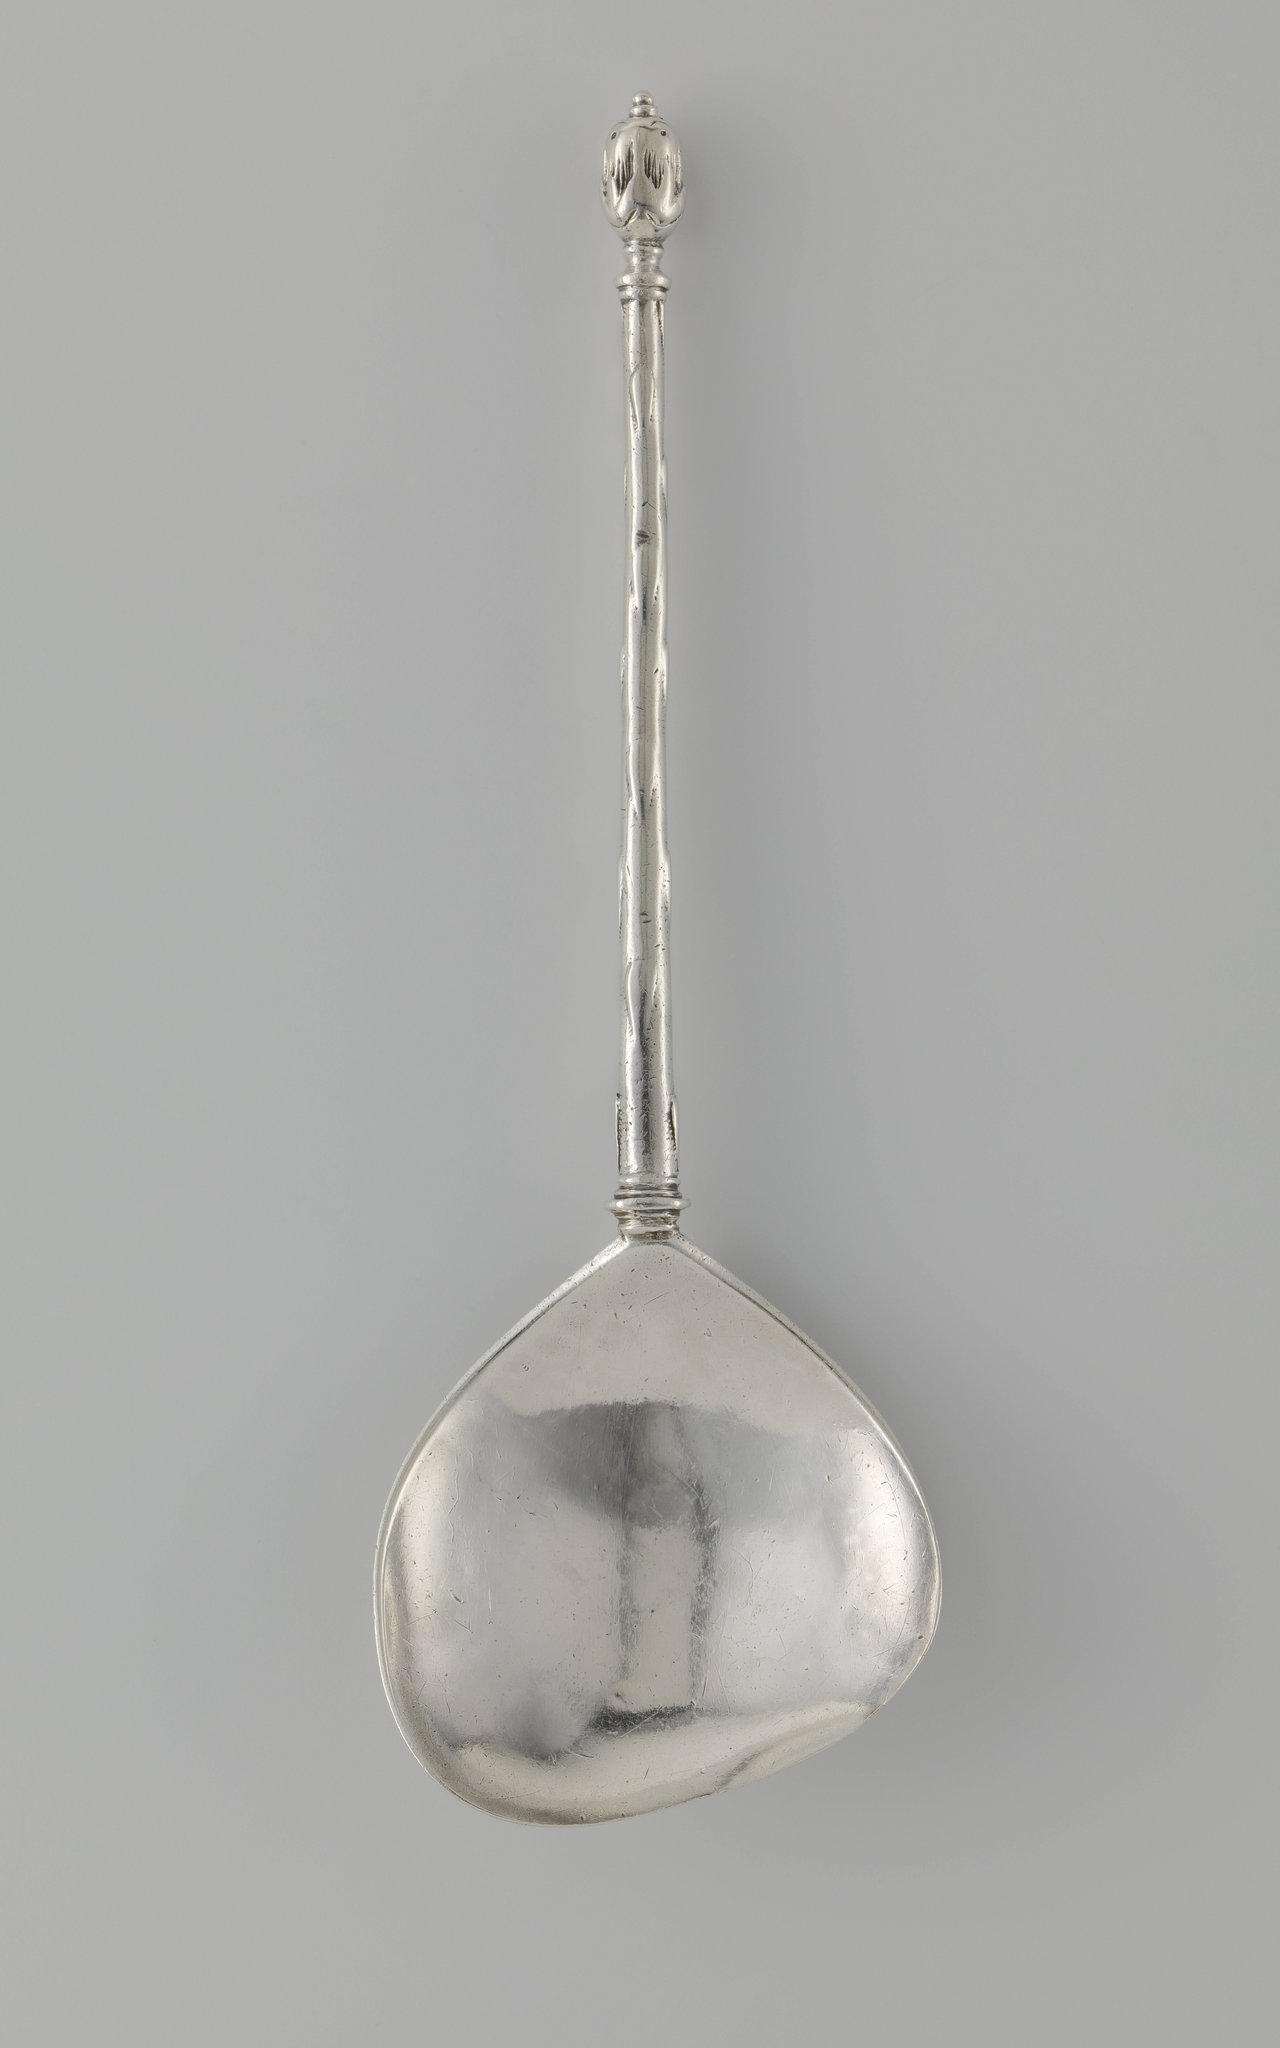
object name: commemorative spoon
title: Gedachtenislepel met gegraveerde initialen T.R.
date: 1670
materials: silver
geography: hoorn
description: Gedachtenislepel van zilver met een ronde, naar de steel toelopende bak (beschadigd) met boven een profielrand een rechte steel, versierd met spitse bladeren en afgesloten door een knop in kelk op een klein profiel. Gegraveerde initialen T.R. Merk: Hoorn, met een klokje en de jaarletter G.